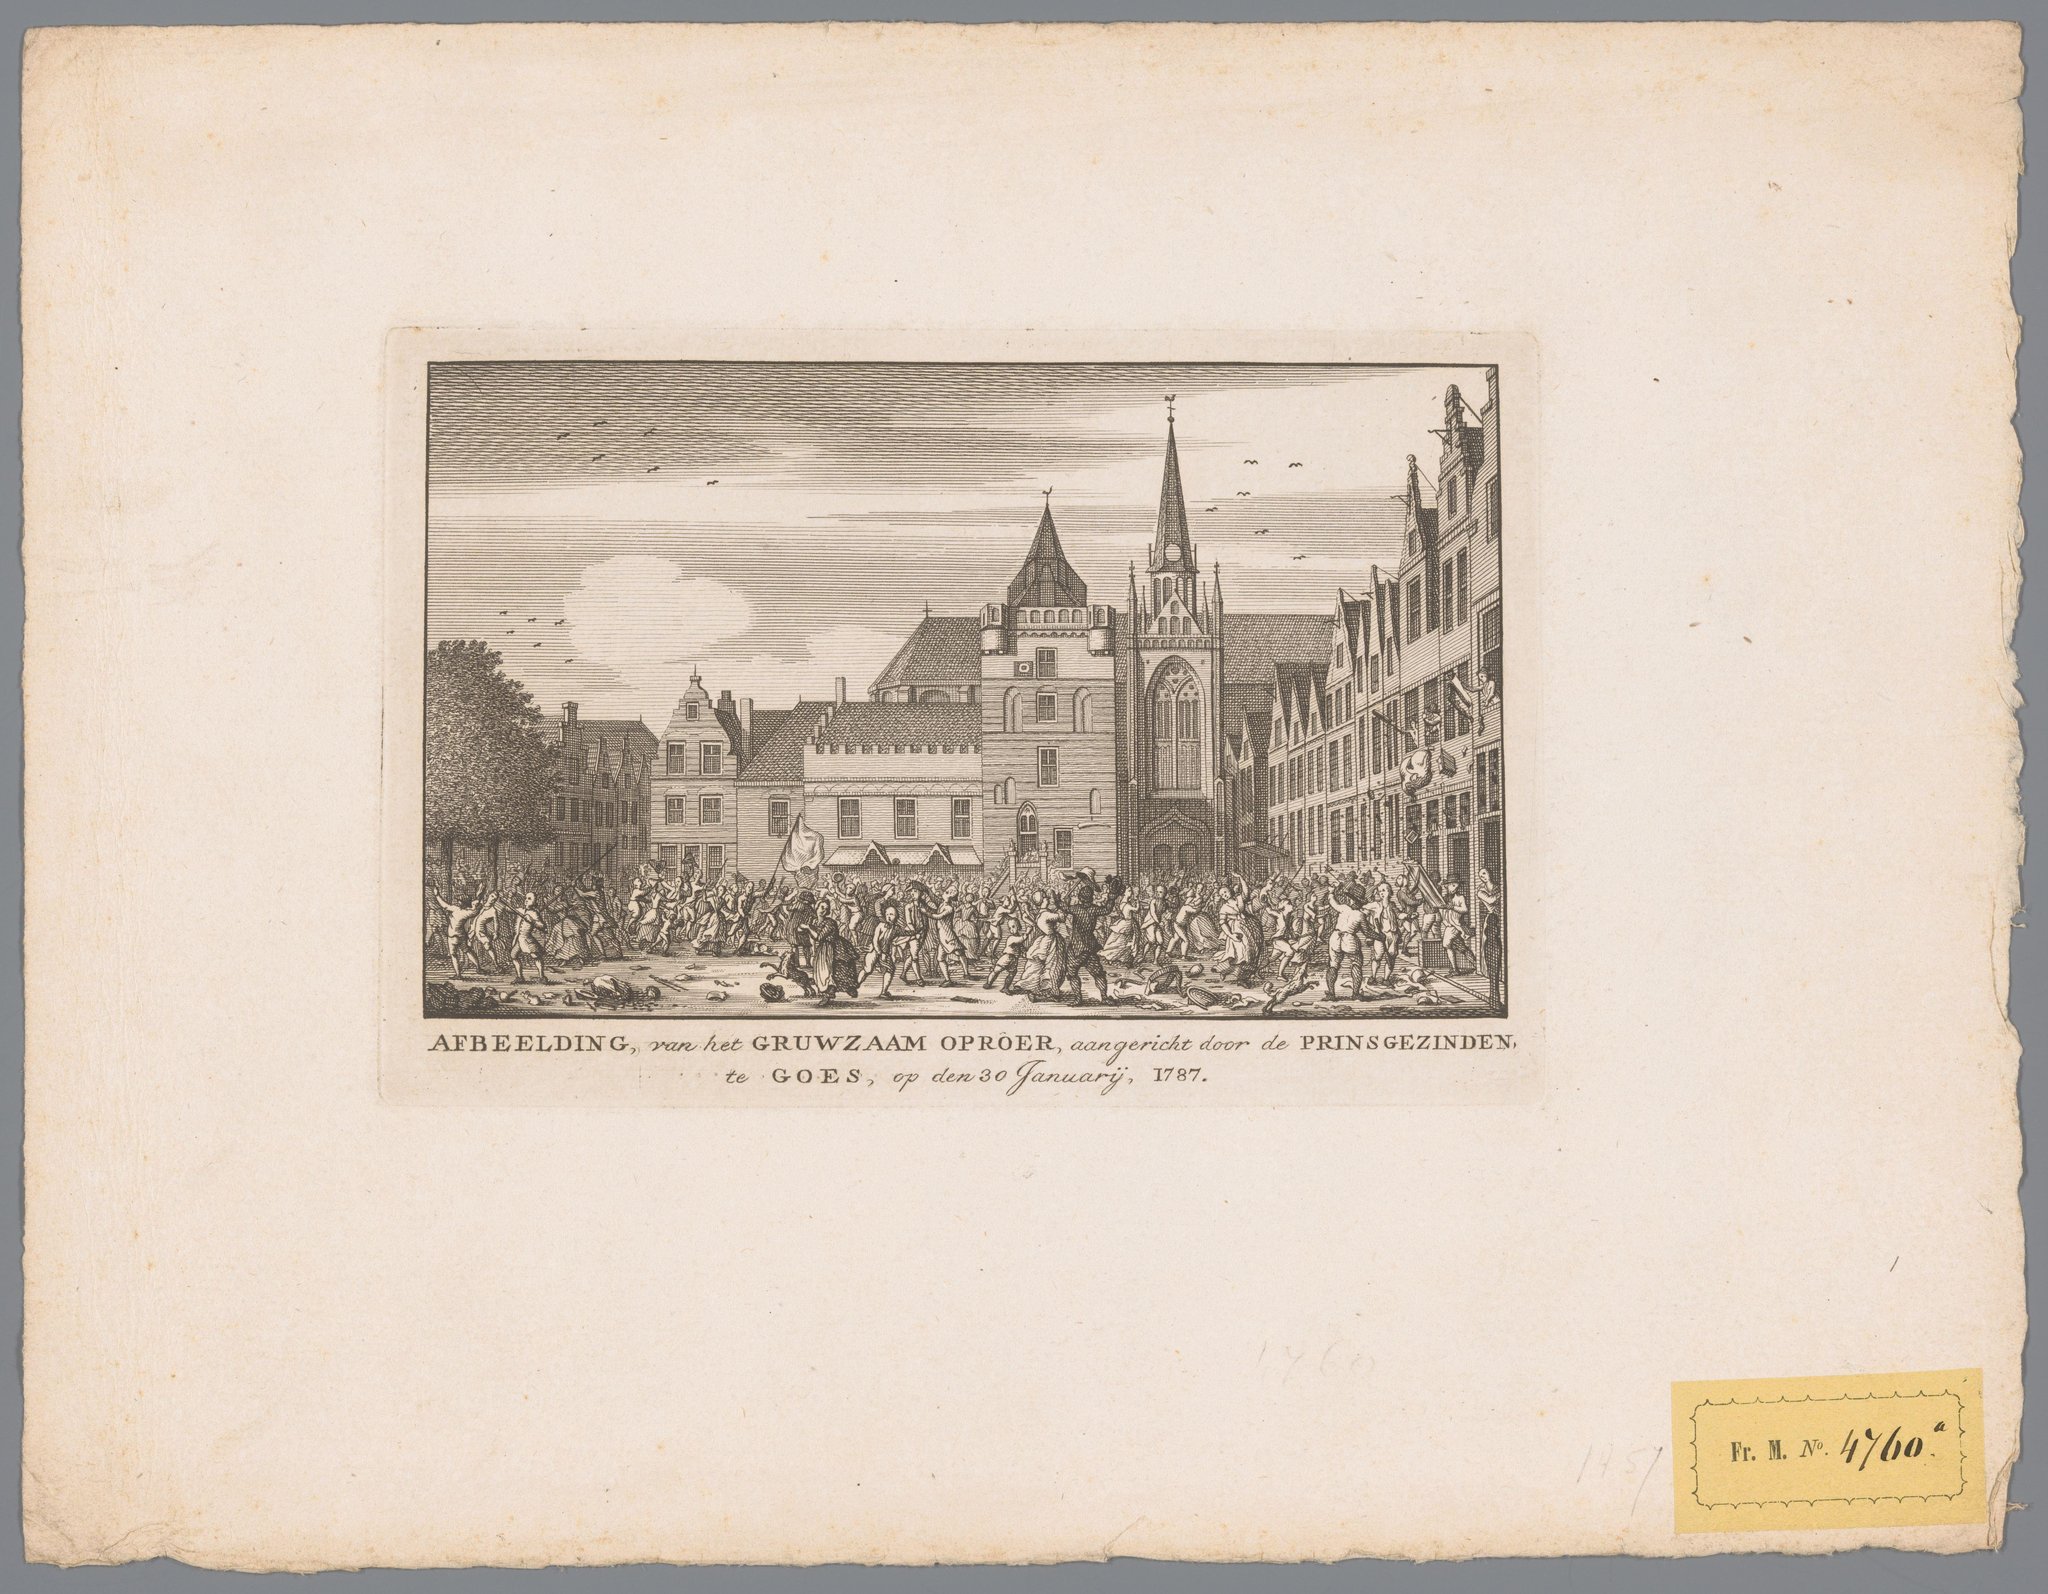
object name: print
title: Afbeelding, van het Gruwzaam Oproer, aangericht door de Prinsgezinden, te Goes, op den 30 Januarij, 1787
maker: Anonymous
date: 1787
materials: paper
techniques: etching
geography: northern netherlands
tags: street-fights, riots, patriots (1780-1795)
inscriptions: label: ‘Fr. M. No. 4760a’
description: Het oproer aangesticht door Prinsgezinden op de markt te Goes, 30 januari 1787. Gezicht op de Markt met het stadhuis en de Grote Kerk.